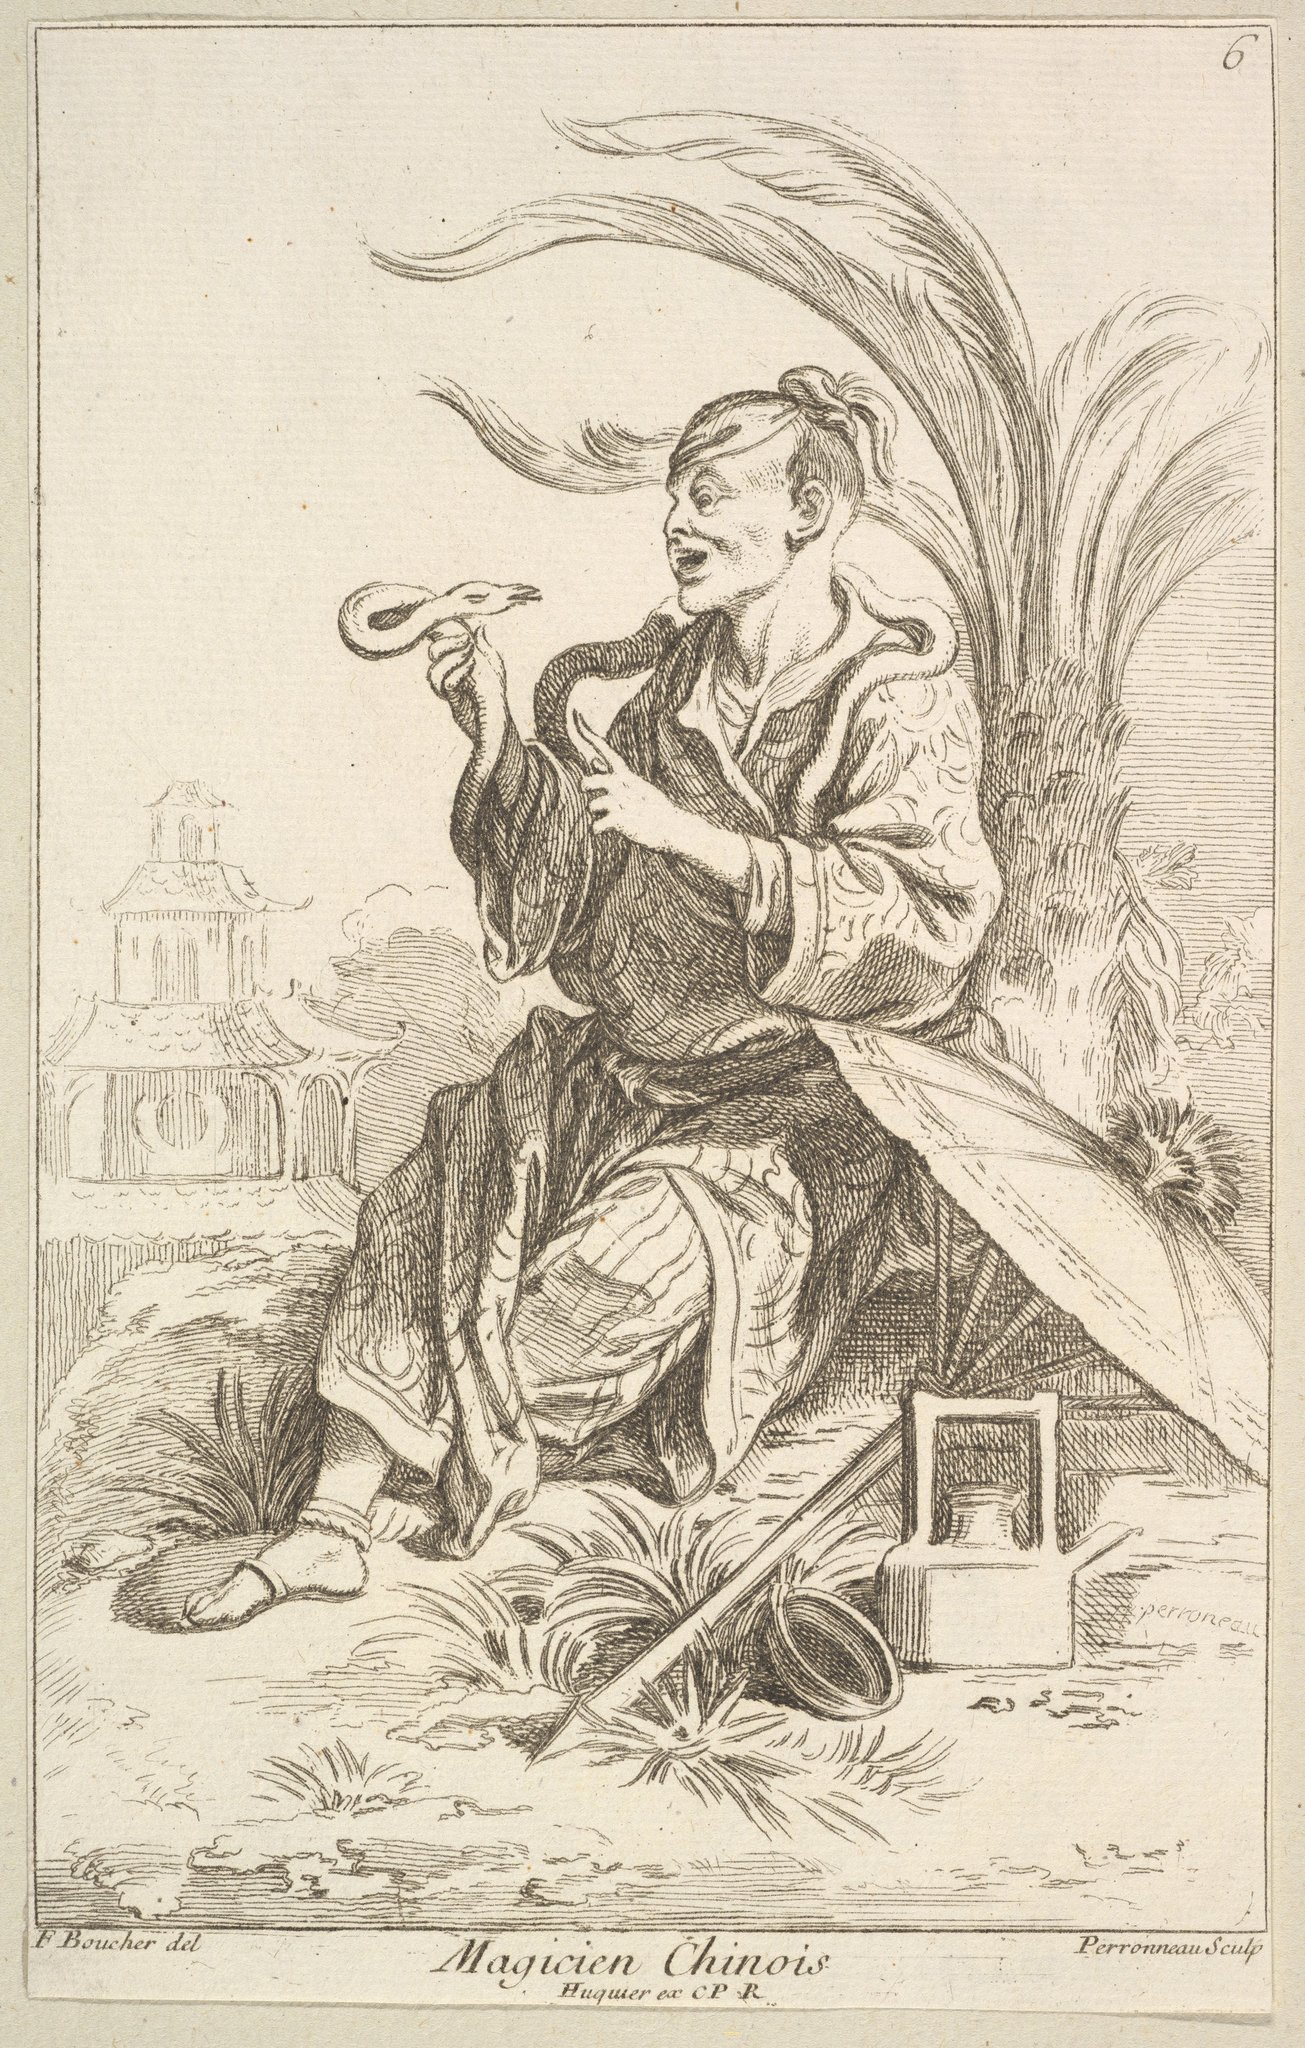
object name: print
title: Chinese Magician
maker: jean-baptiste perronneau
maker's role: artist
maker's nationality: french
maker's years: 1715-1783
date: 1738-1745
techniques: etching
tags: men,snakes,magicians